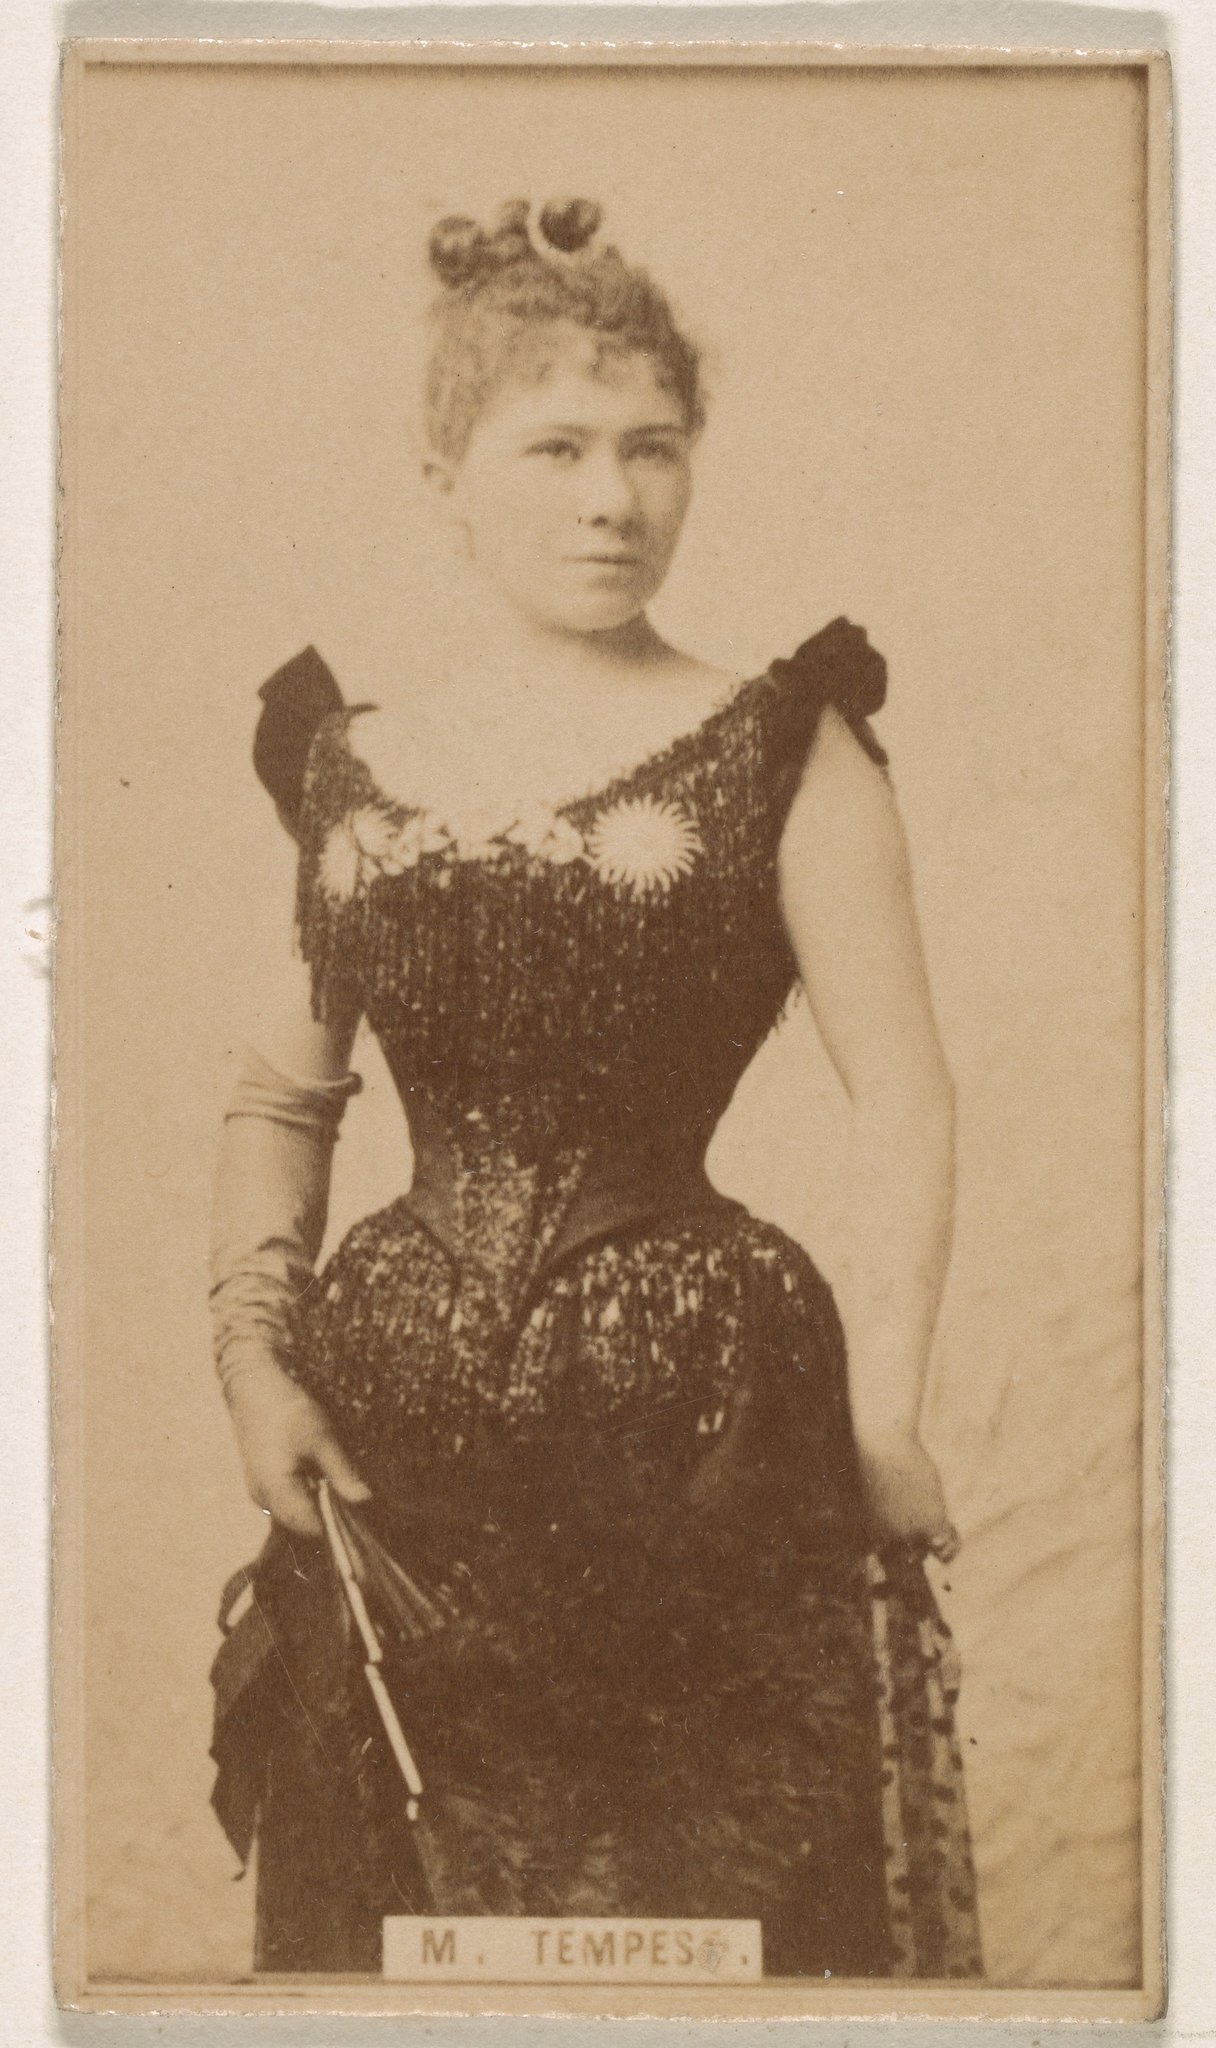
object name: photograph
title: Marie Tempest, from the Actresses series (N245) issued by Kinney Brothers to promote Sweet Caporal Cigarettes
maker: kinney brothers tobacco company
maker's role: publisher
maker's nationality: american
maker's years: 1869-2011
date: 1890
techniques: albumen silver print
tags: portraits,women,actresses